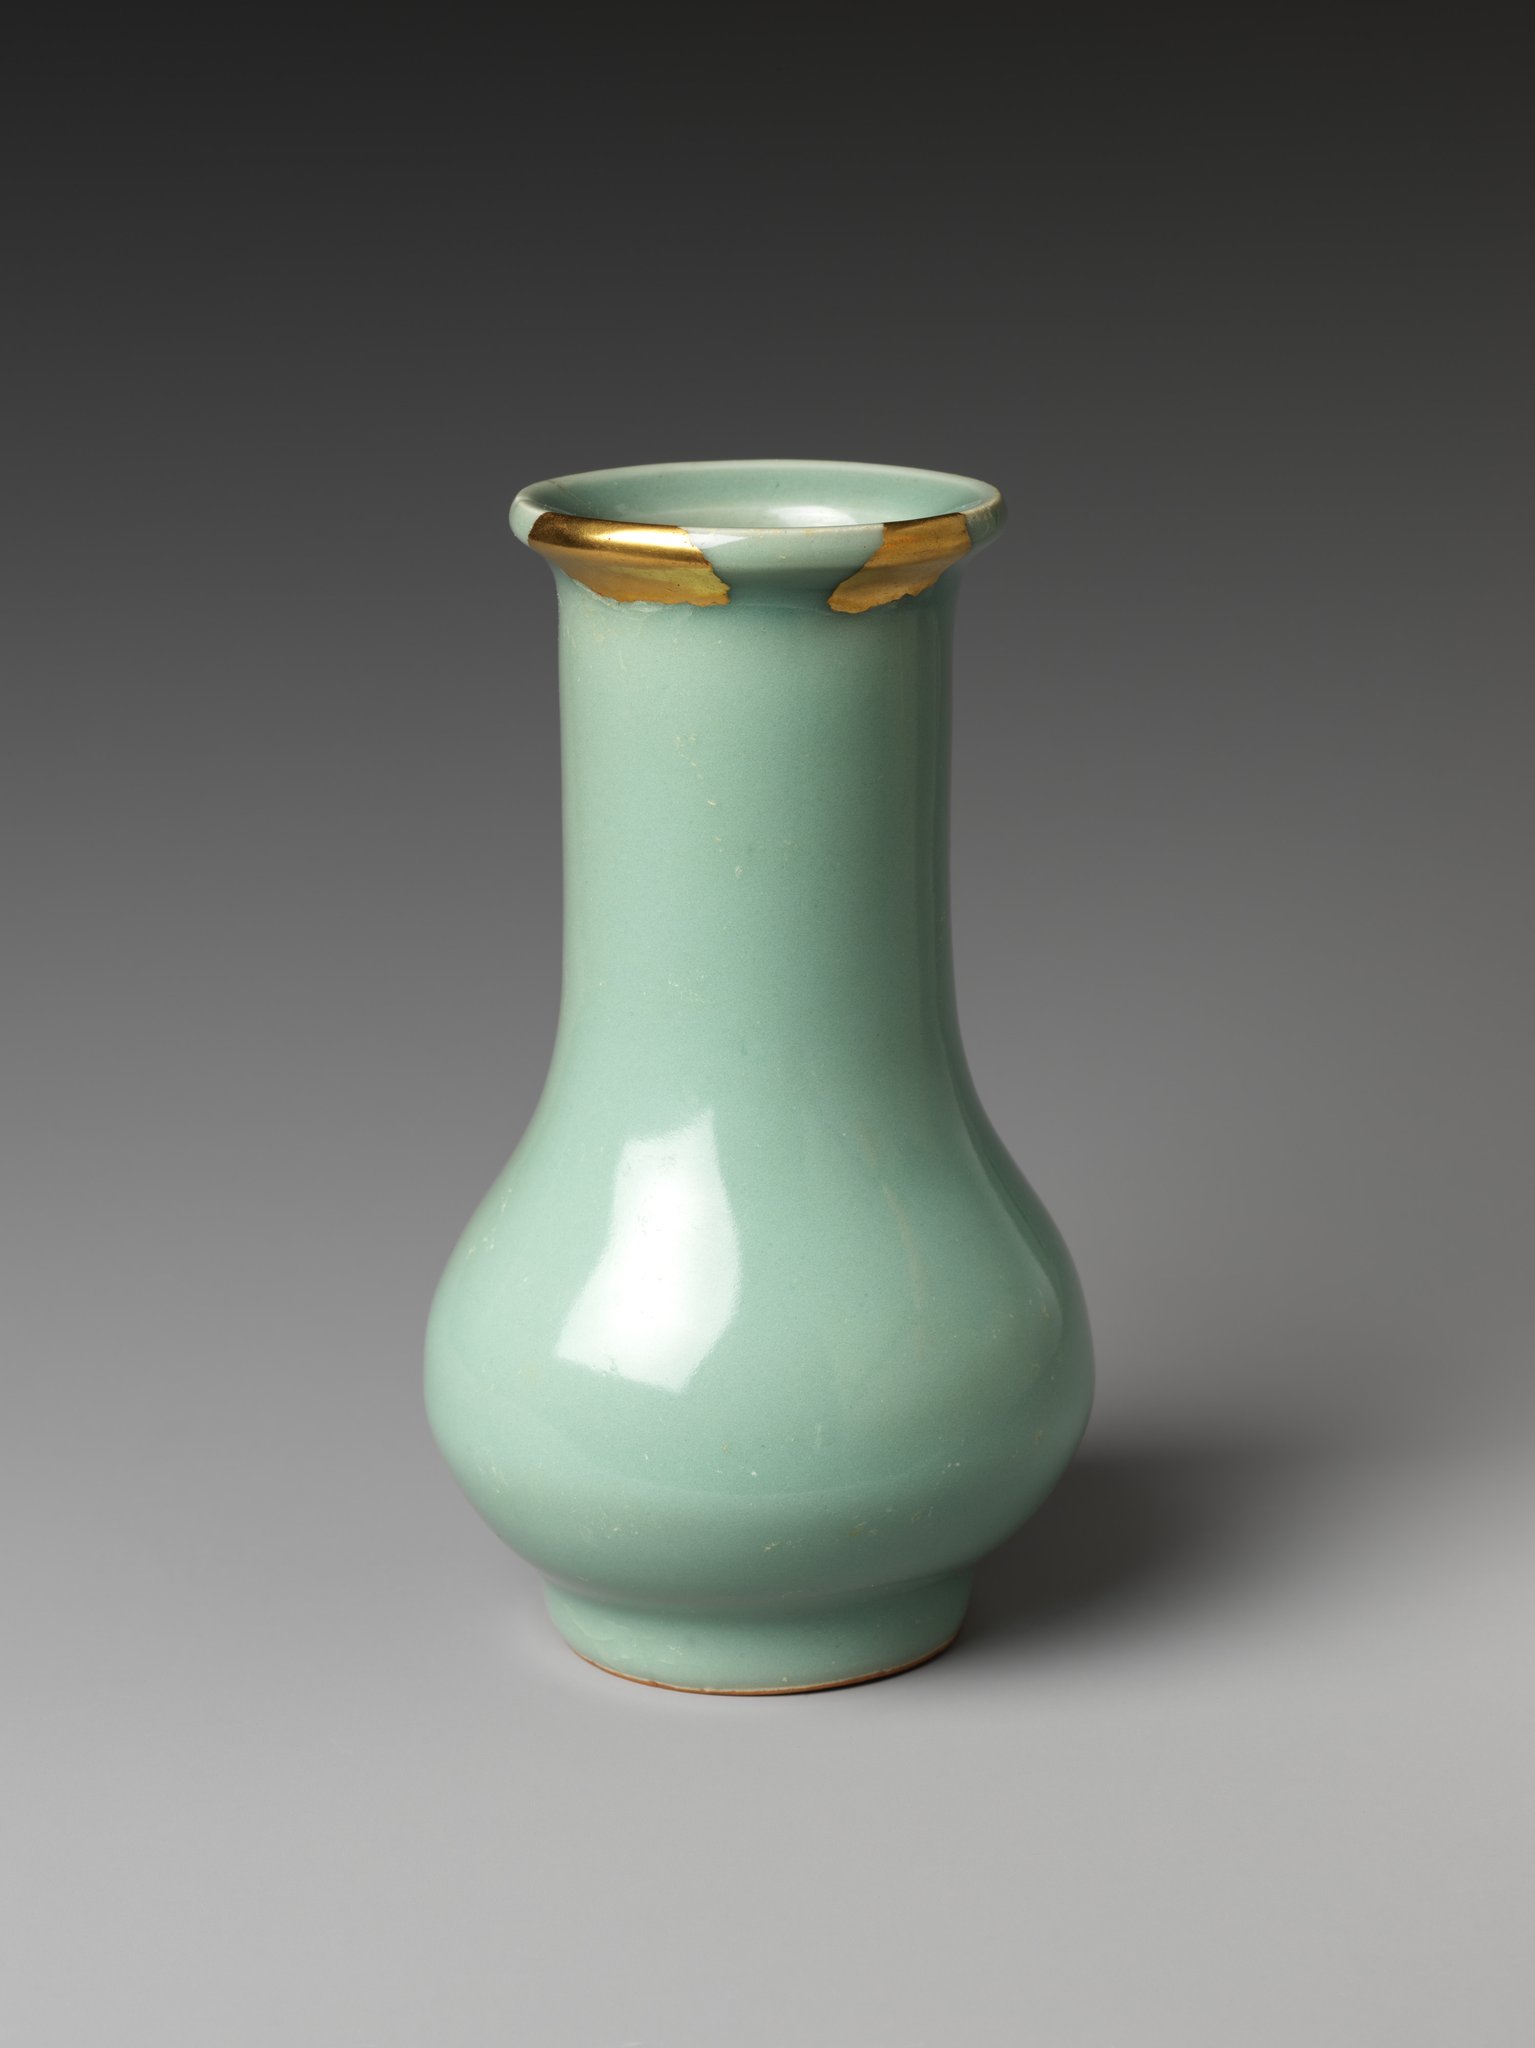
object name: vase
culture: chinese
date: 1127-1279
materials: ceramic glaze, glaze, gold, lacquer, stoneware